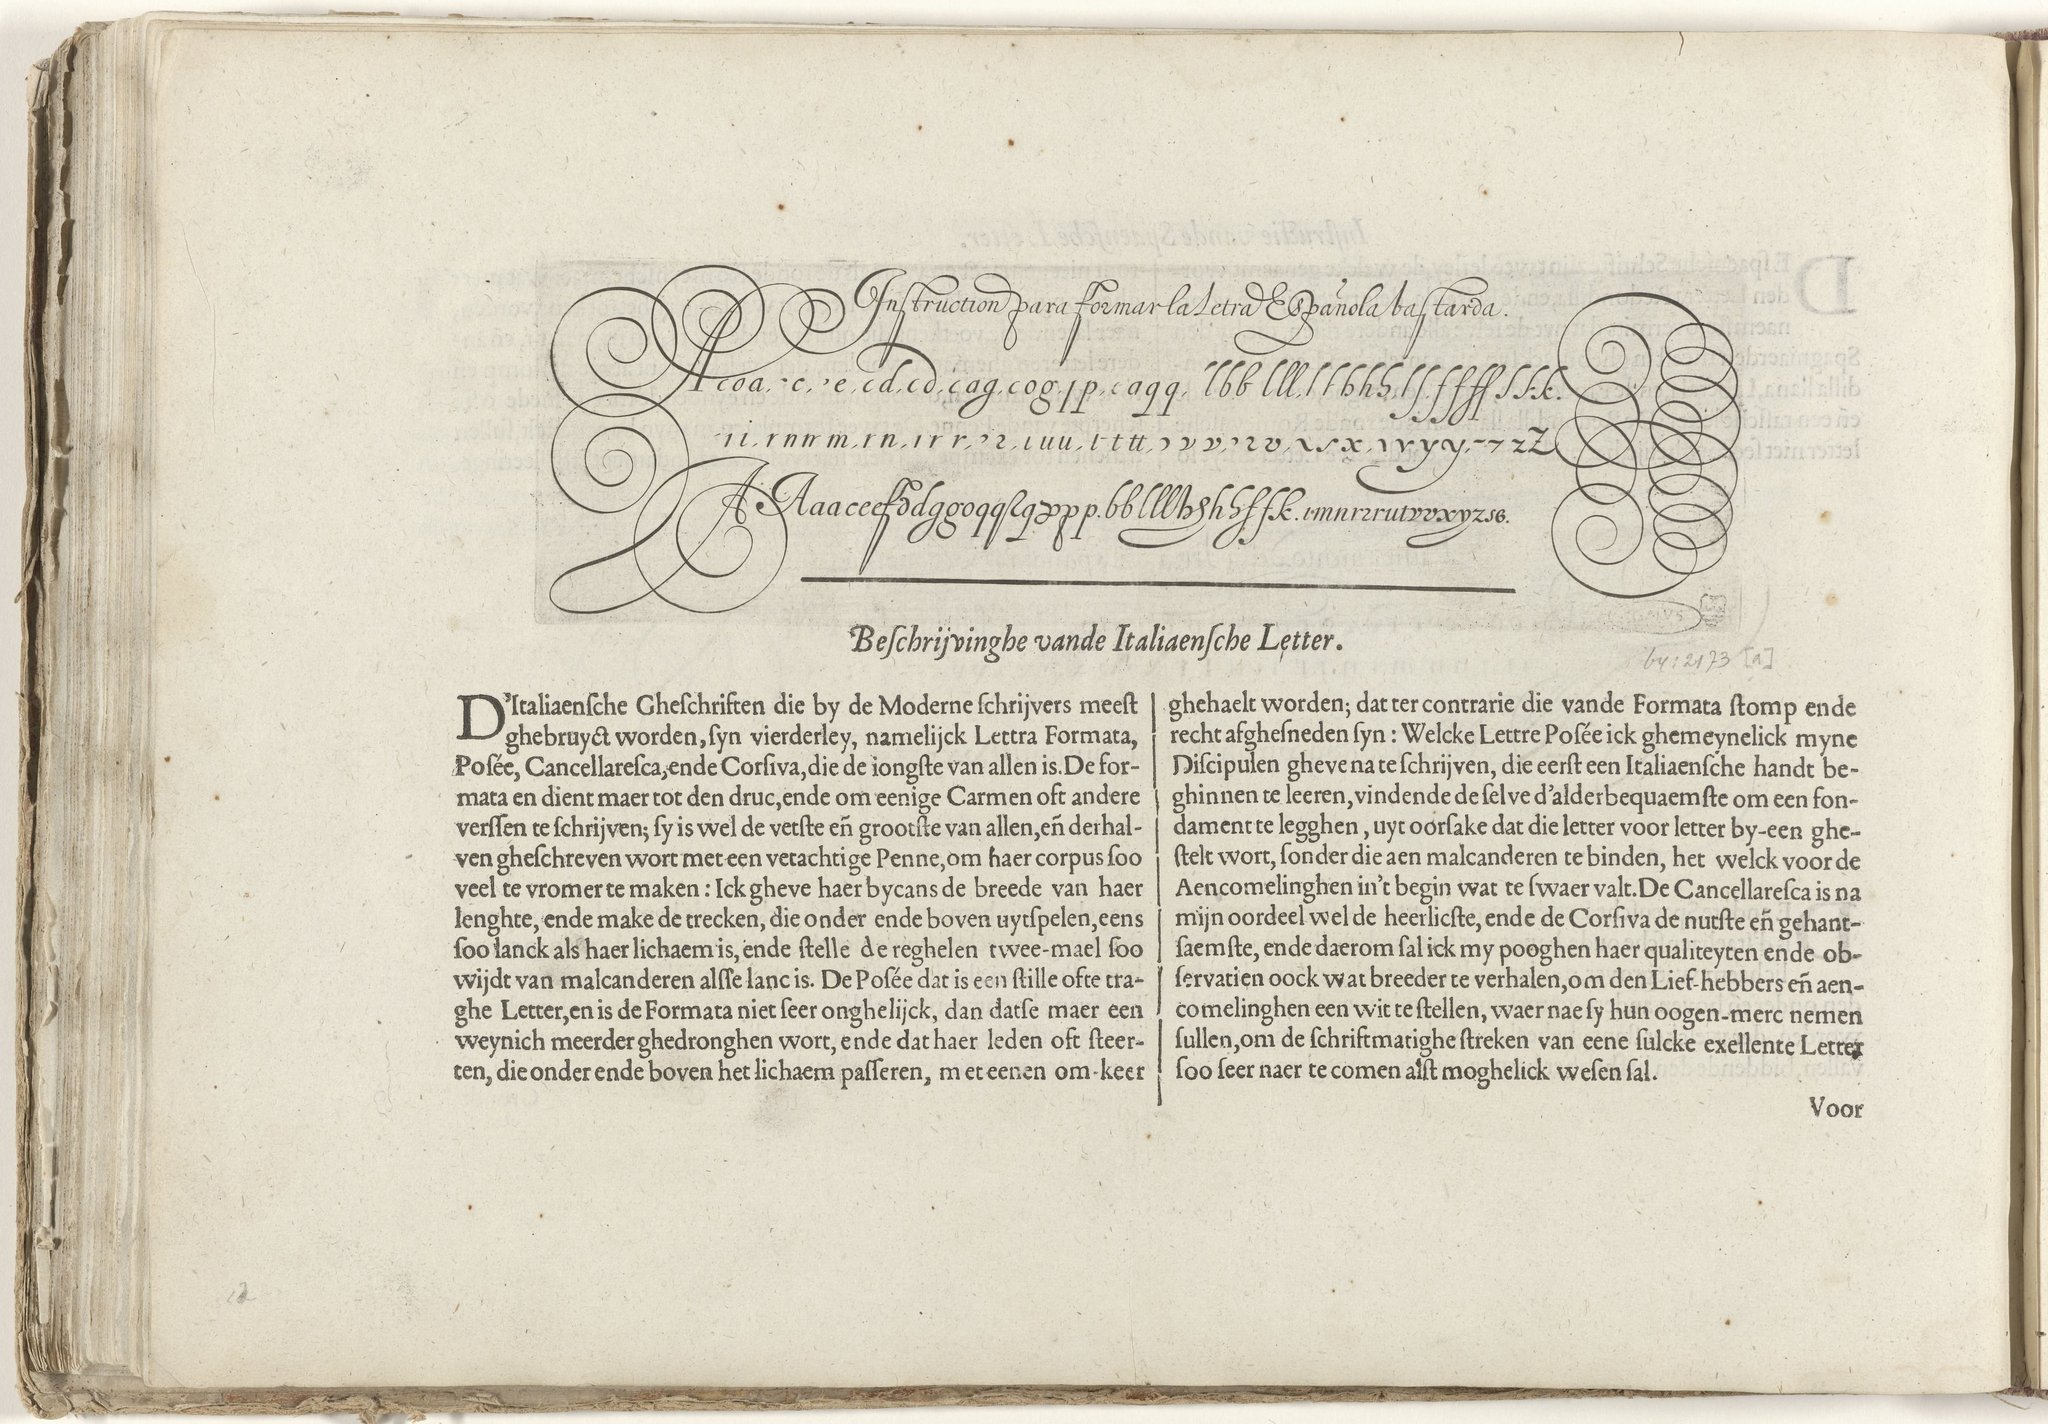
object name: album leaf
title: Schrijfvoorbeeld van de Spaensche Lettera Bastarde en het begin van de beschrijving over de Italiaanse handen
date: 1605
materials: paper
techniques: engraving, letterpress printing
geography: amsterdam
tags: calligraphy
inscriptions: collector's mark: Lugt 2228, collector's mark: Lugt 2760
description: Folio C1v met een schrijfvoorbeeld getiteld: Instruction para formarla letra Espanola bastarda. Daaronder het begin van de beschrijving over de Italiaanse handen. Het blad maakt deel uit van een album.